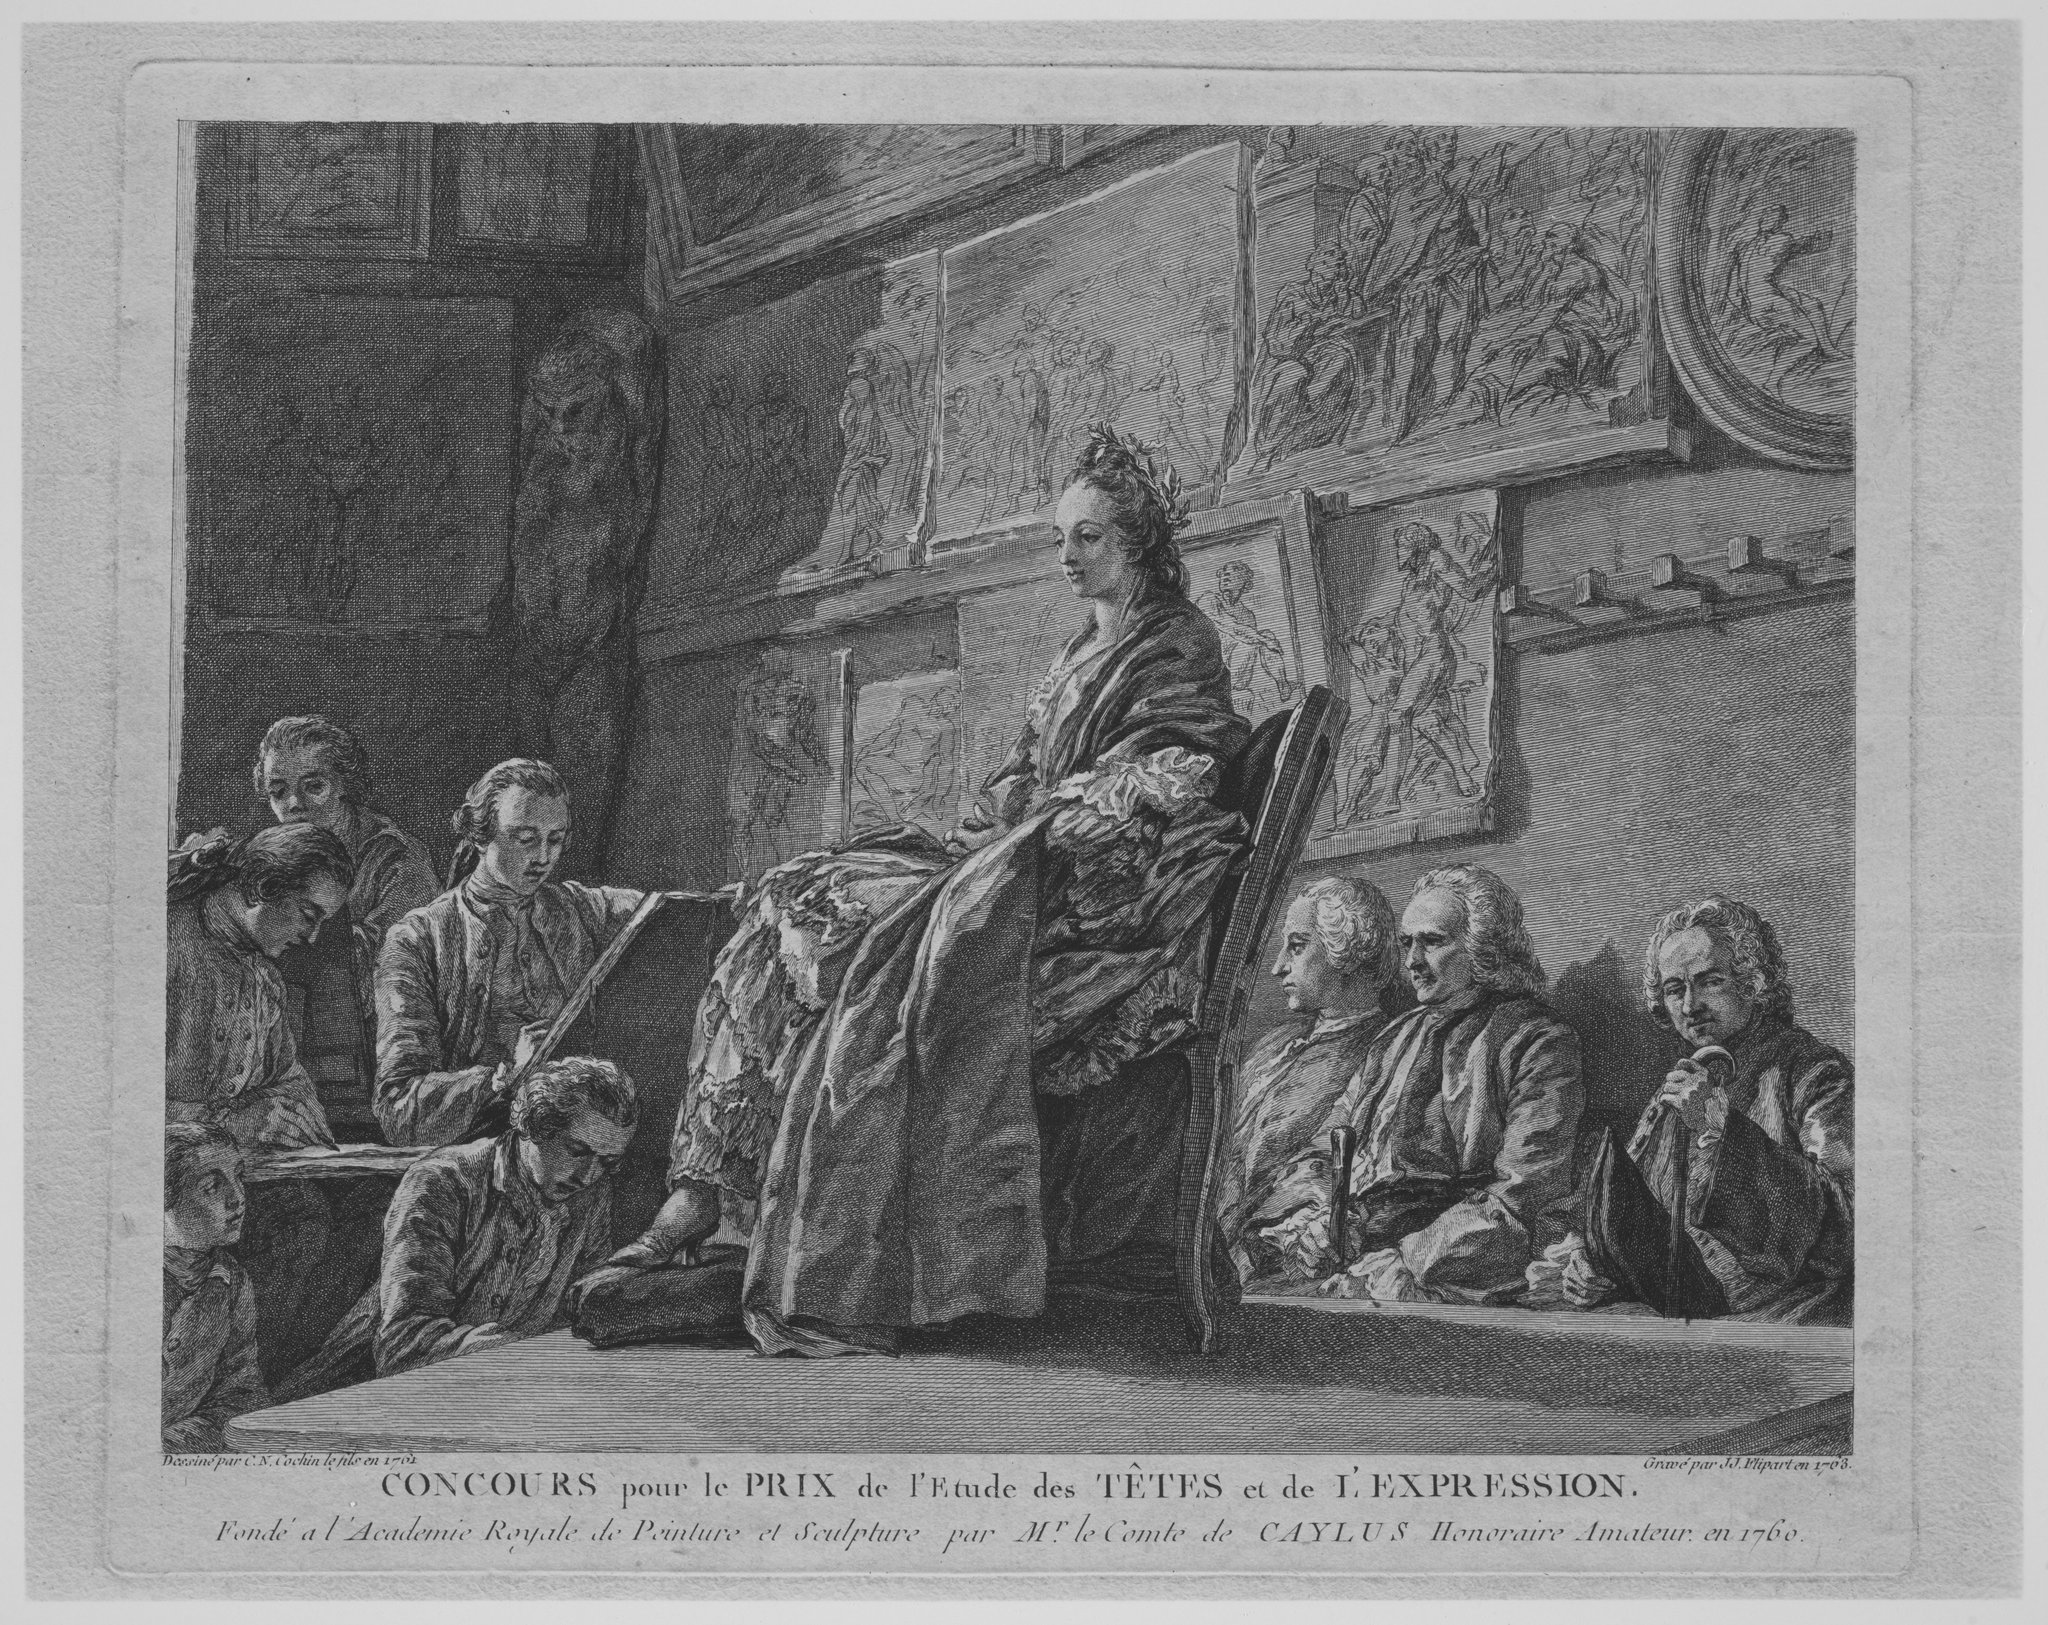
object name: print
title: Concours pour le Prix de l'Etude des Têtes et de l'Expression (Portrait of Mlle. Clairon)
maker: charles nicolas cochin ii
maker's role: artist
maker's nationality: french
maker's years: 1715-1790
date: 1763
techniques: engraving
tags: drawing,men,women